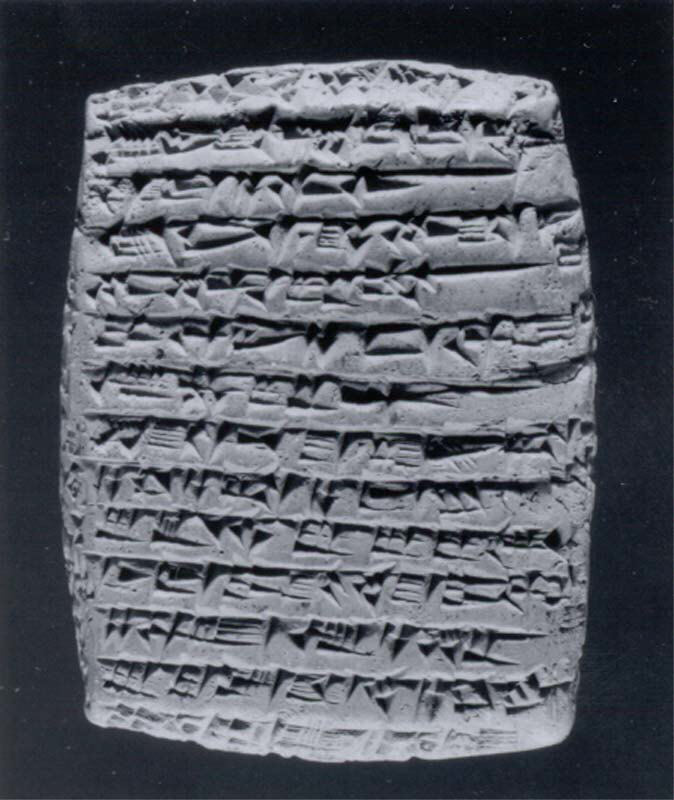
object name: cuneiform tablet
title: Cuneiform tablet: private letter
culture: assyrian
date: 2000-1801 BCE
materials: clay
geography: anatolia